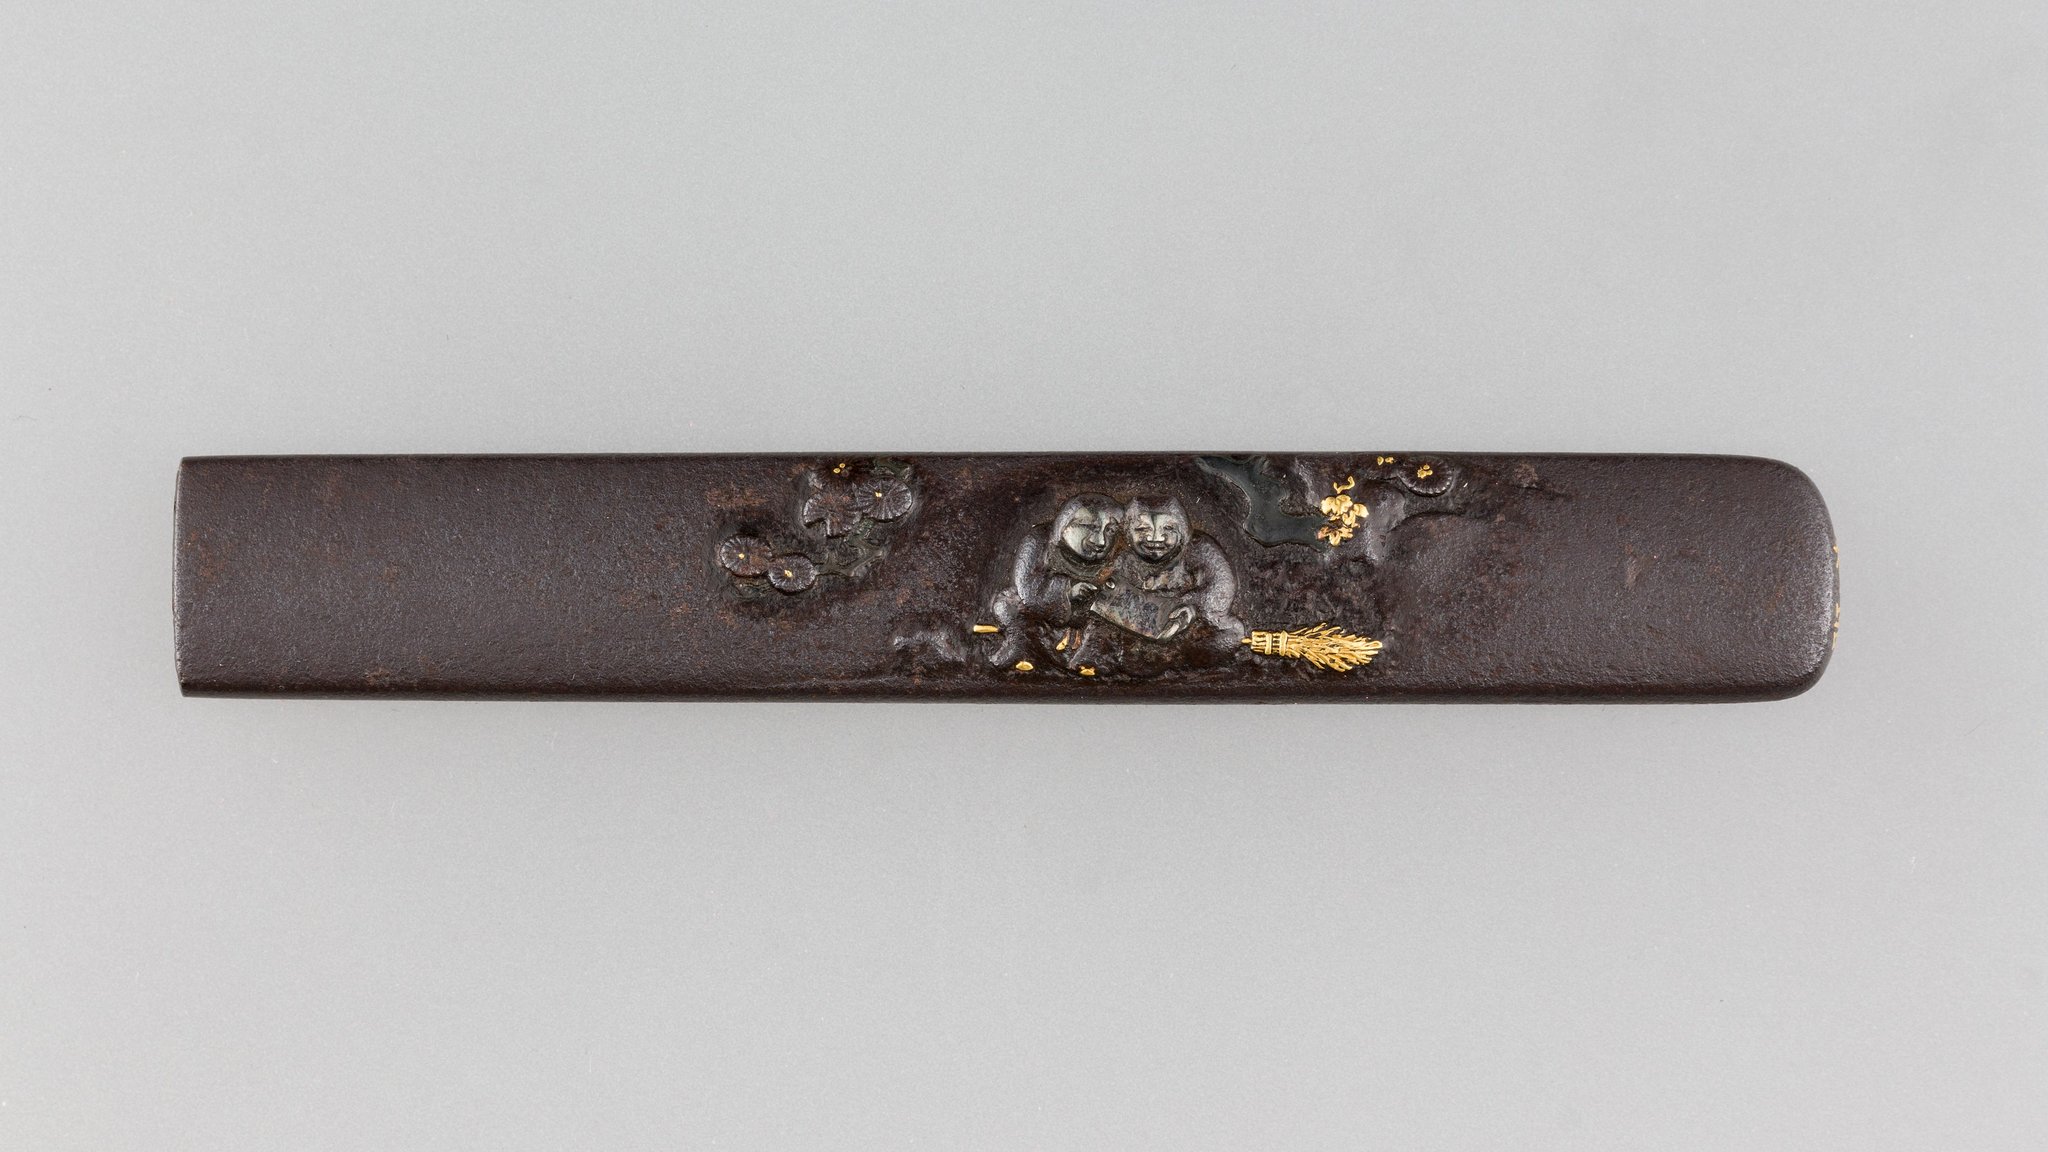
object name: knife handle kozuka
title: Knife Handle (Kozuka)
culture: japanese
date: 1667-1736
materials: gold, iron, silver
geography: japan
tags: human figures